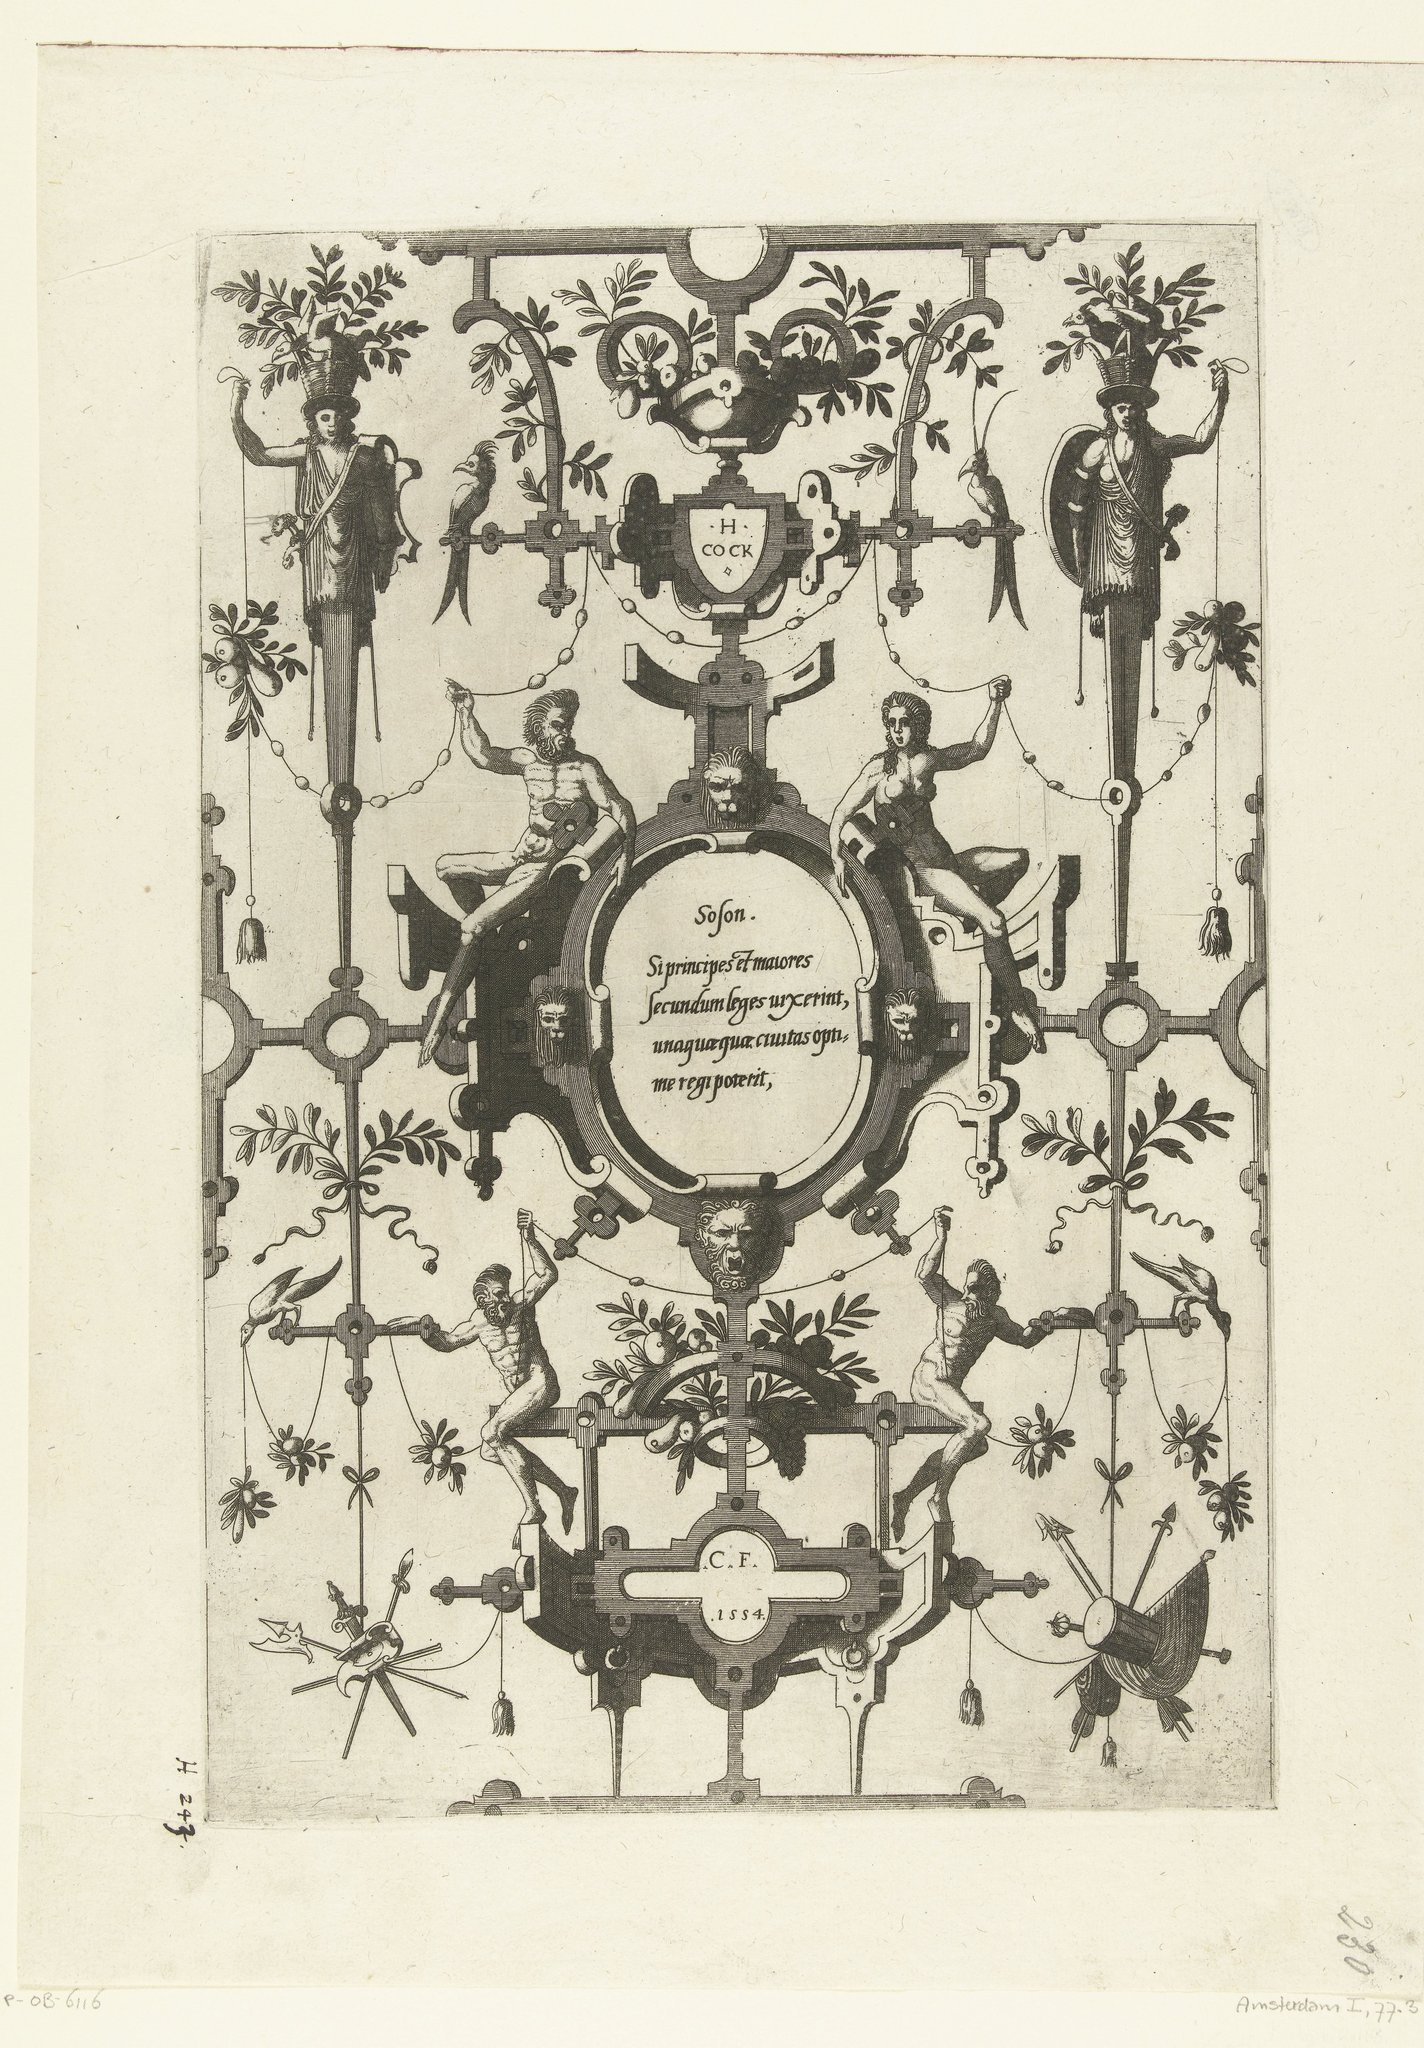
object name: print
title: Vlakdecoraties: cartouches met citaten van filosofen in een omlijsting van rolwerk, grotesken, figuren, guirlandes en trofeeën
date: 1558-1630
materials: paper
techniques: etching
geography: netherlands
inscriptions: number: ‘H. 243’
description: Op de cartouche zitten een man en een vrouw. Linksboven en rechtsboven staan hermen, linksonder en rechtsonder hangen wapentrofeeën. Hoort bij serie van 6 bladen.